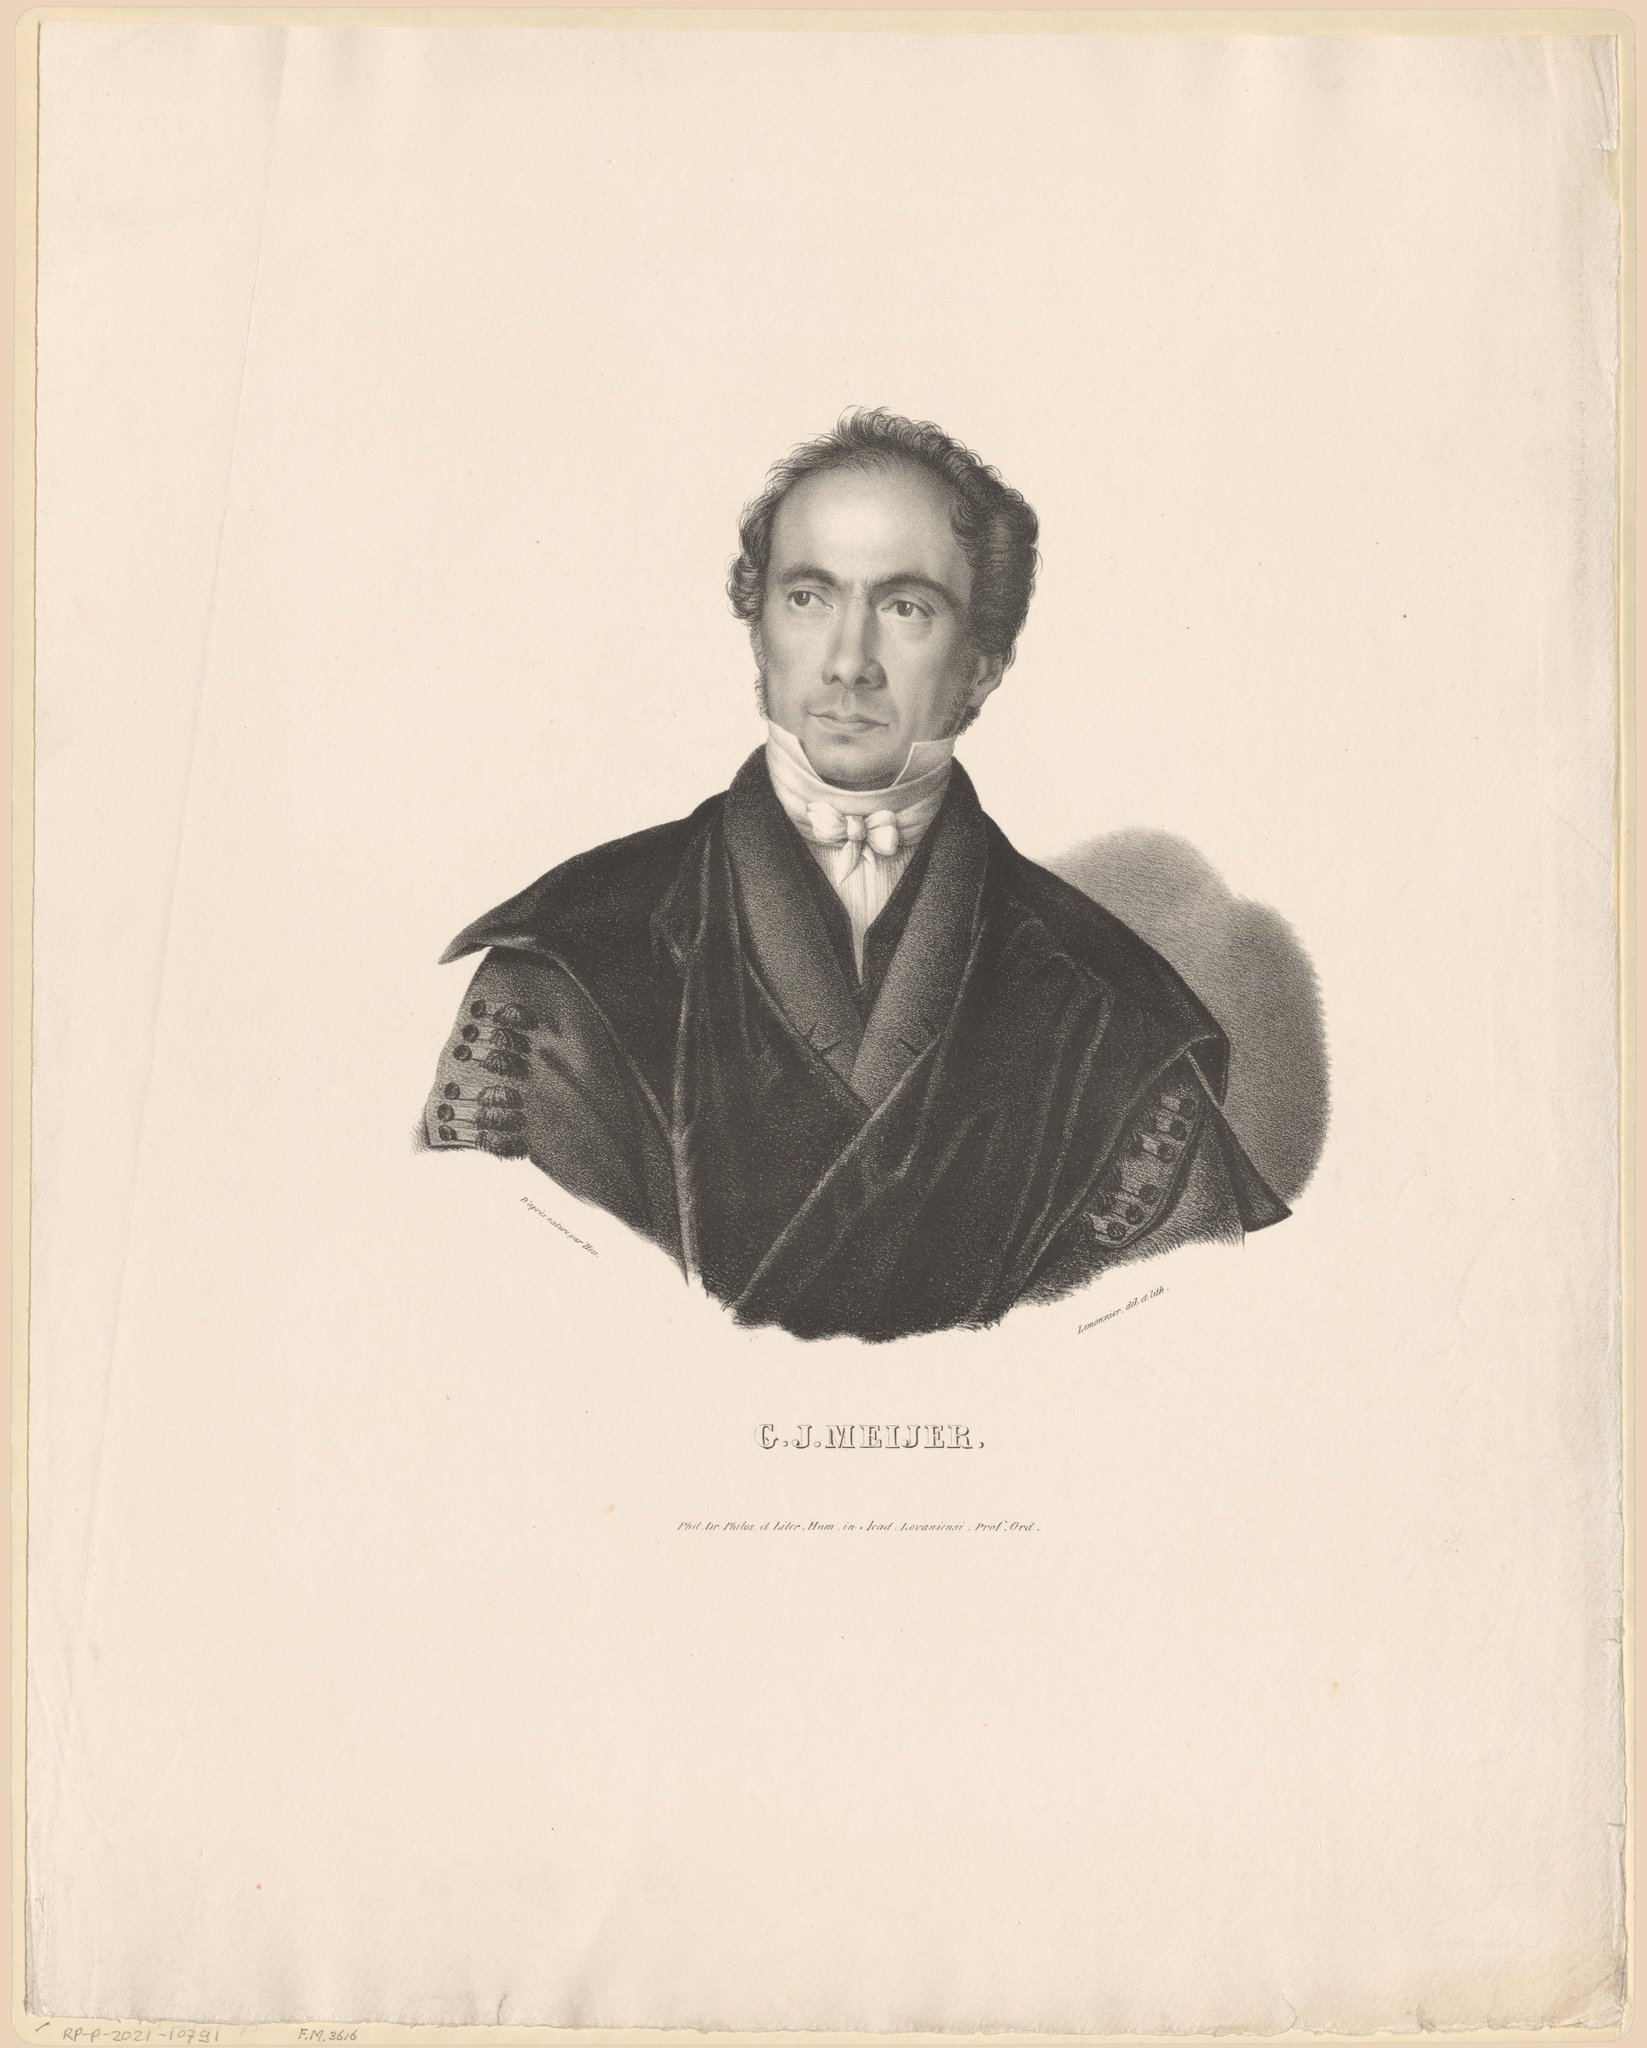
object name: print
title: Iconographie des professeurs des universites des Pays-Bas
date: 1827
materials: paper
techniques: lithograph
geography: brussels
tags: cleves, groningen (province), historical persons, professor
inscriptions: collector's mark: Lugt 2228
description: Prent waarschijnlijk uit: Hess, Marcel. Iconographie des professeurs des universites des Pays-Bas (...). 3 dln. Brussel: Antoine Lemonnier, 1827.